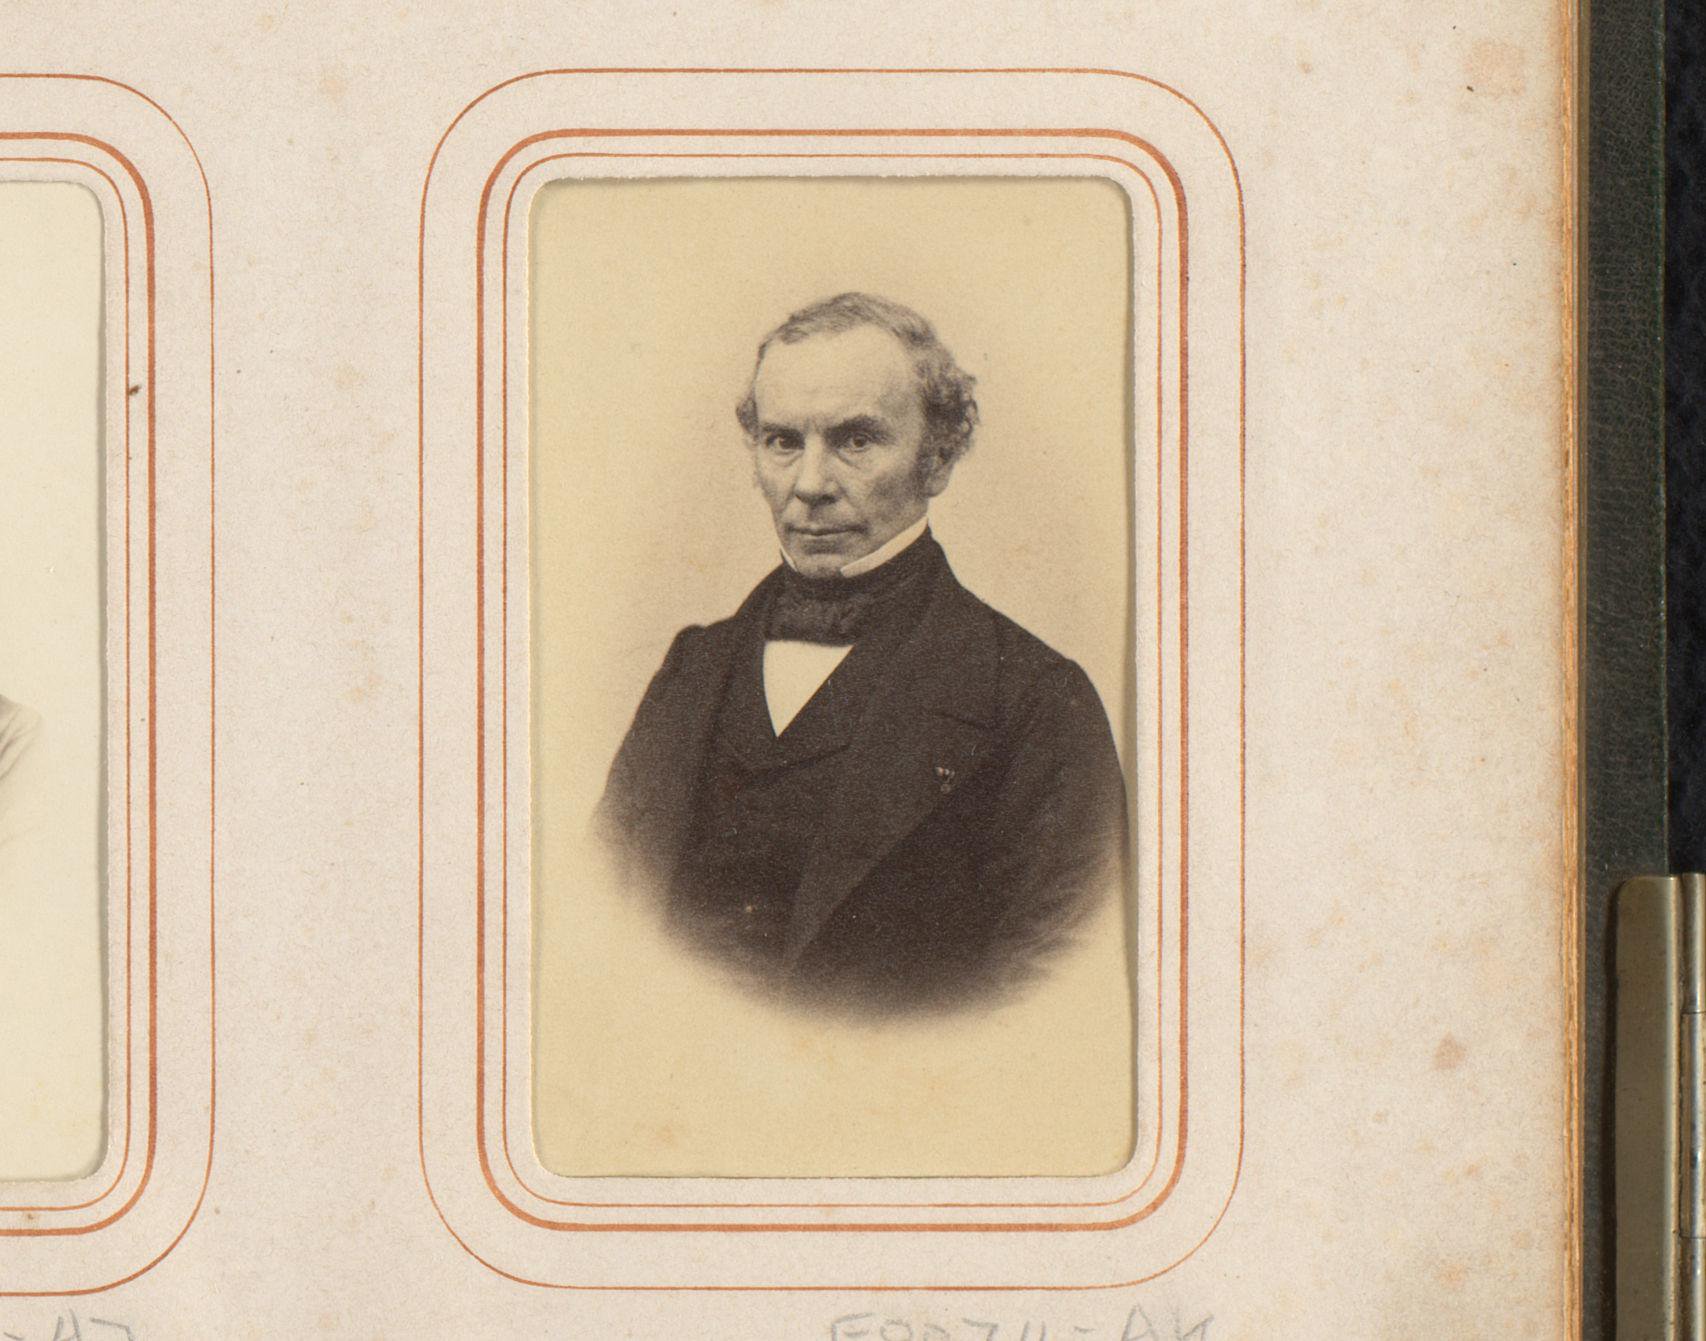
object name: photograph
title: Portret van een man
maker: f. galand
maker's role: fotograaf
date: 1855-1880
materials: cardboard, photographic support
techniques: albumen print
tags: historical persons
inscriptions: inscription: ‘F. Galand/ Fotograaf’